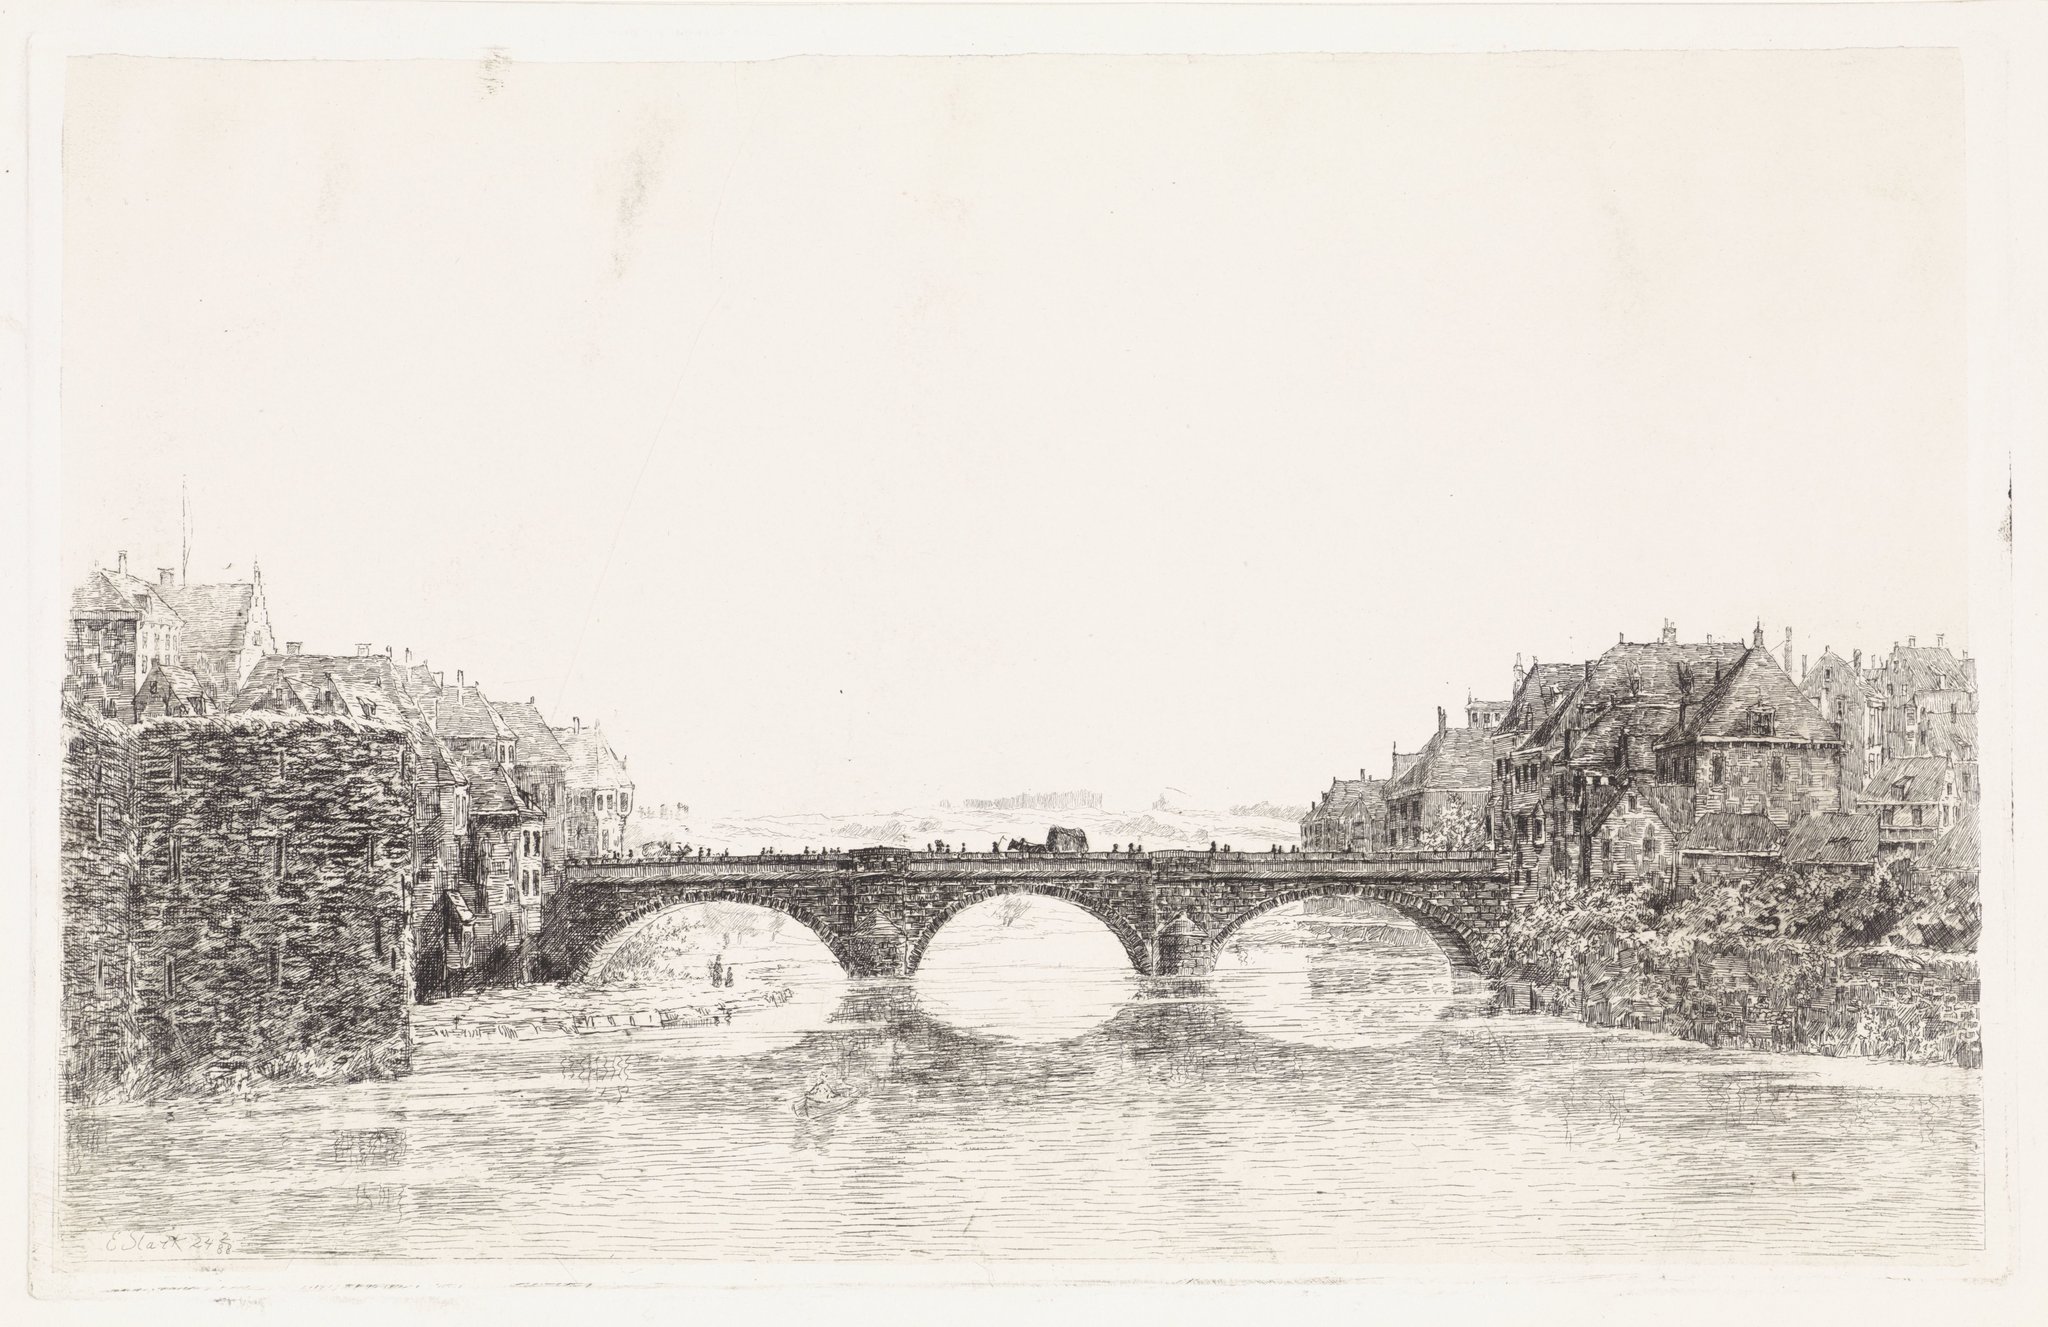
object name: print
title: Brug over de Fulda te Kassel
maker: elias stark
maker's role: draughtsman, print maker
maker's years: 1849-1933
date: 1888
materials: paper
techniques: etching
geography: kassel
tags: bridge in city across river, canal, etc.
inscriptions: collector's mark: Lugt 2228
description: De brug over de rivier de Fulda te Kassel.